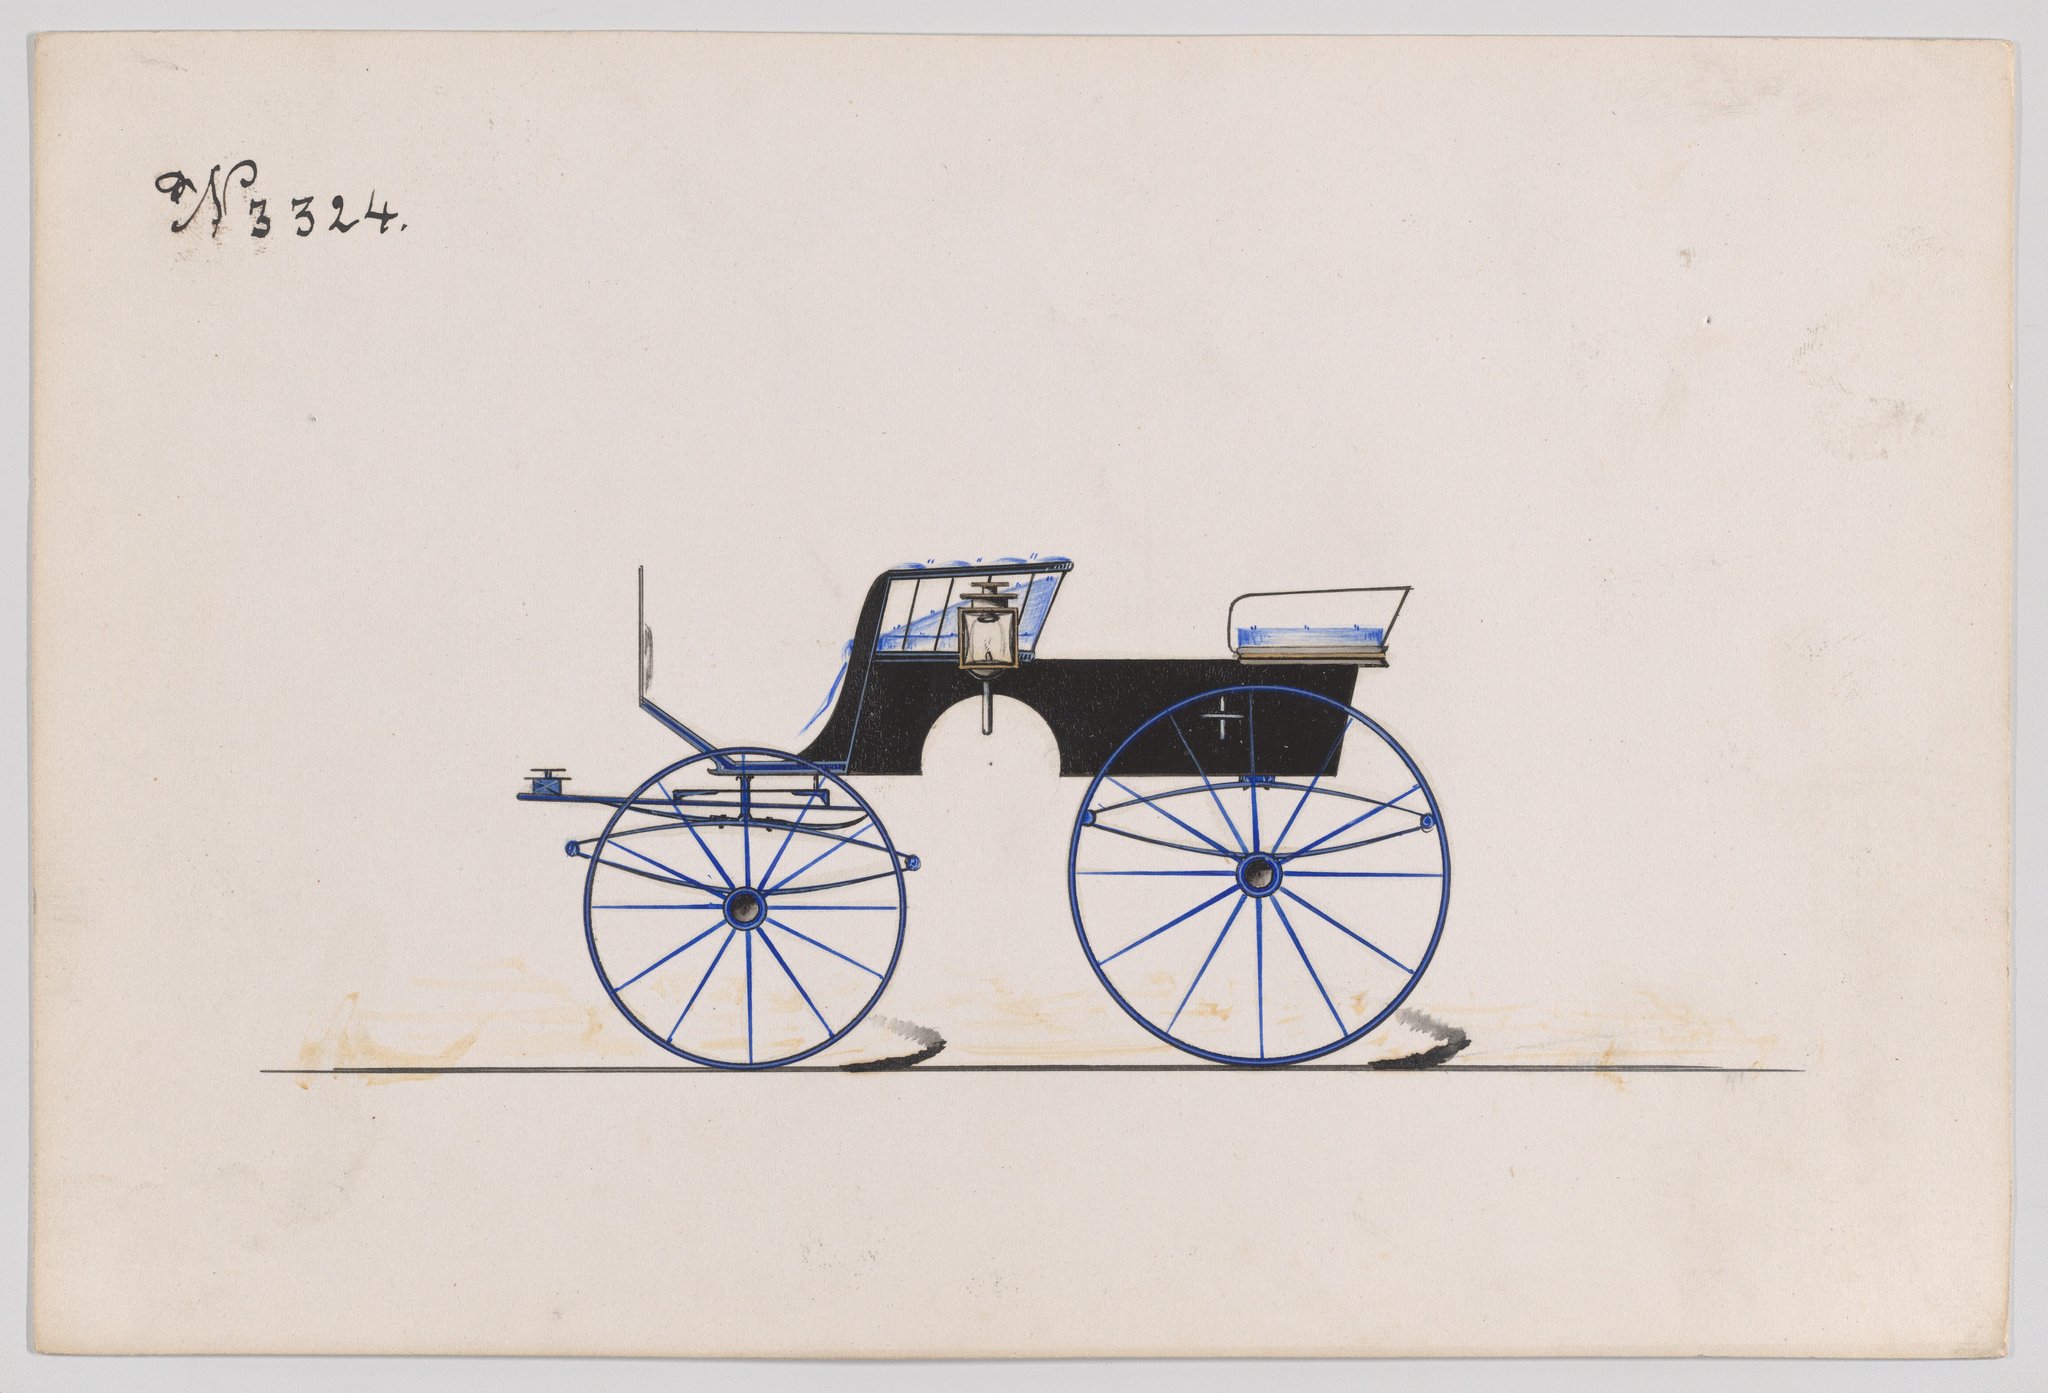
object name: drawing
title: Design for T-Cart, no. 3324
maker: brewster & co.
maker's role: manufacturer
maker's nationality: american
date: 1877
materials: gouache, gum arabic, ink, watercolor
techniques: pen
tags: carriages